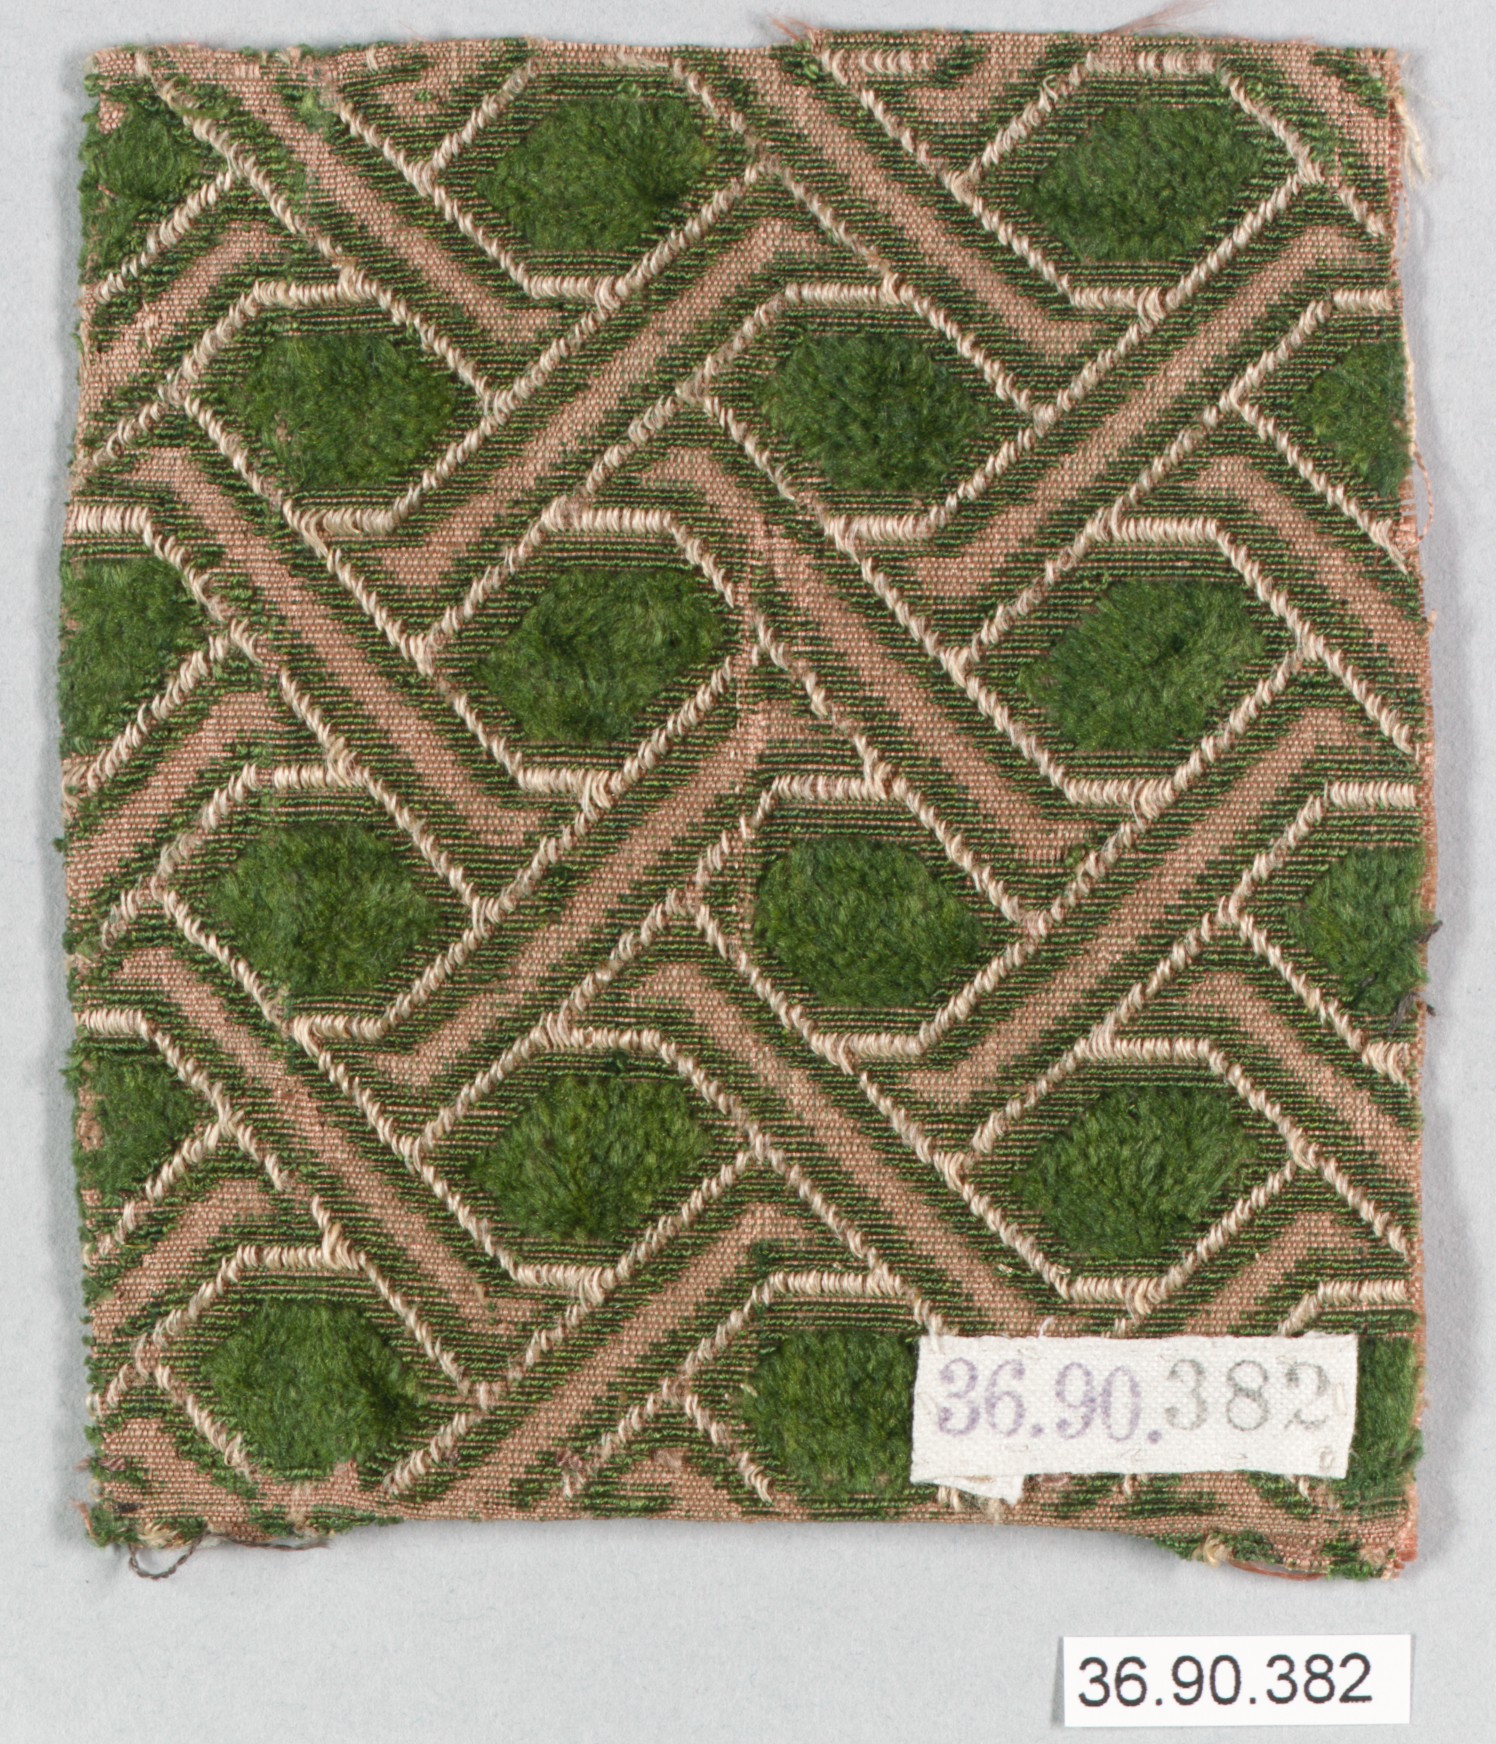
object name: piece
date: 1501-1700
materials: silk